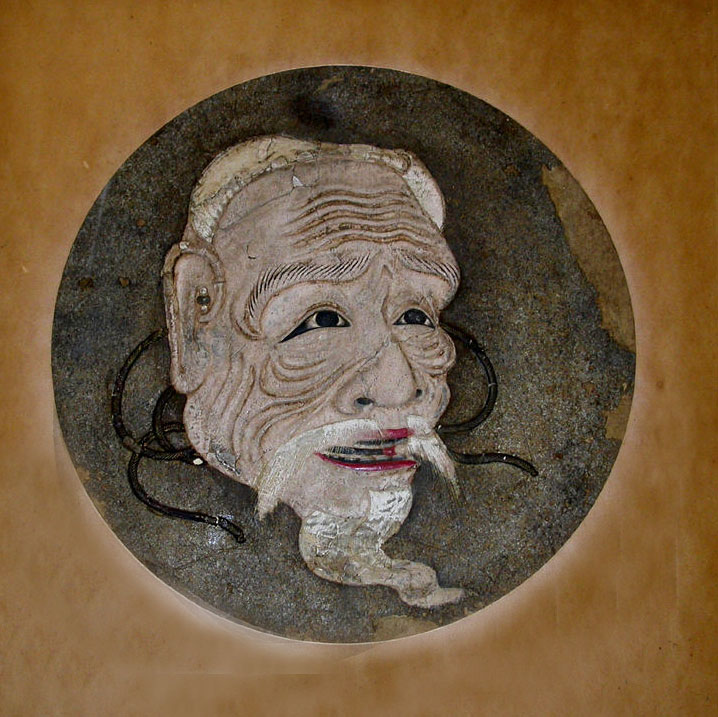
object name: painting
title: Noh Mask of an Old Man (Asakurajō)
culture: japanese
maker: ogawa haritsu (ritsuō)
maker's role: artist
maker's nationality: japanese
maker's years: 1663-1747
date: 1701-1800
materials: paper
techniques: painting, relief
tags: heads,men